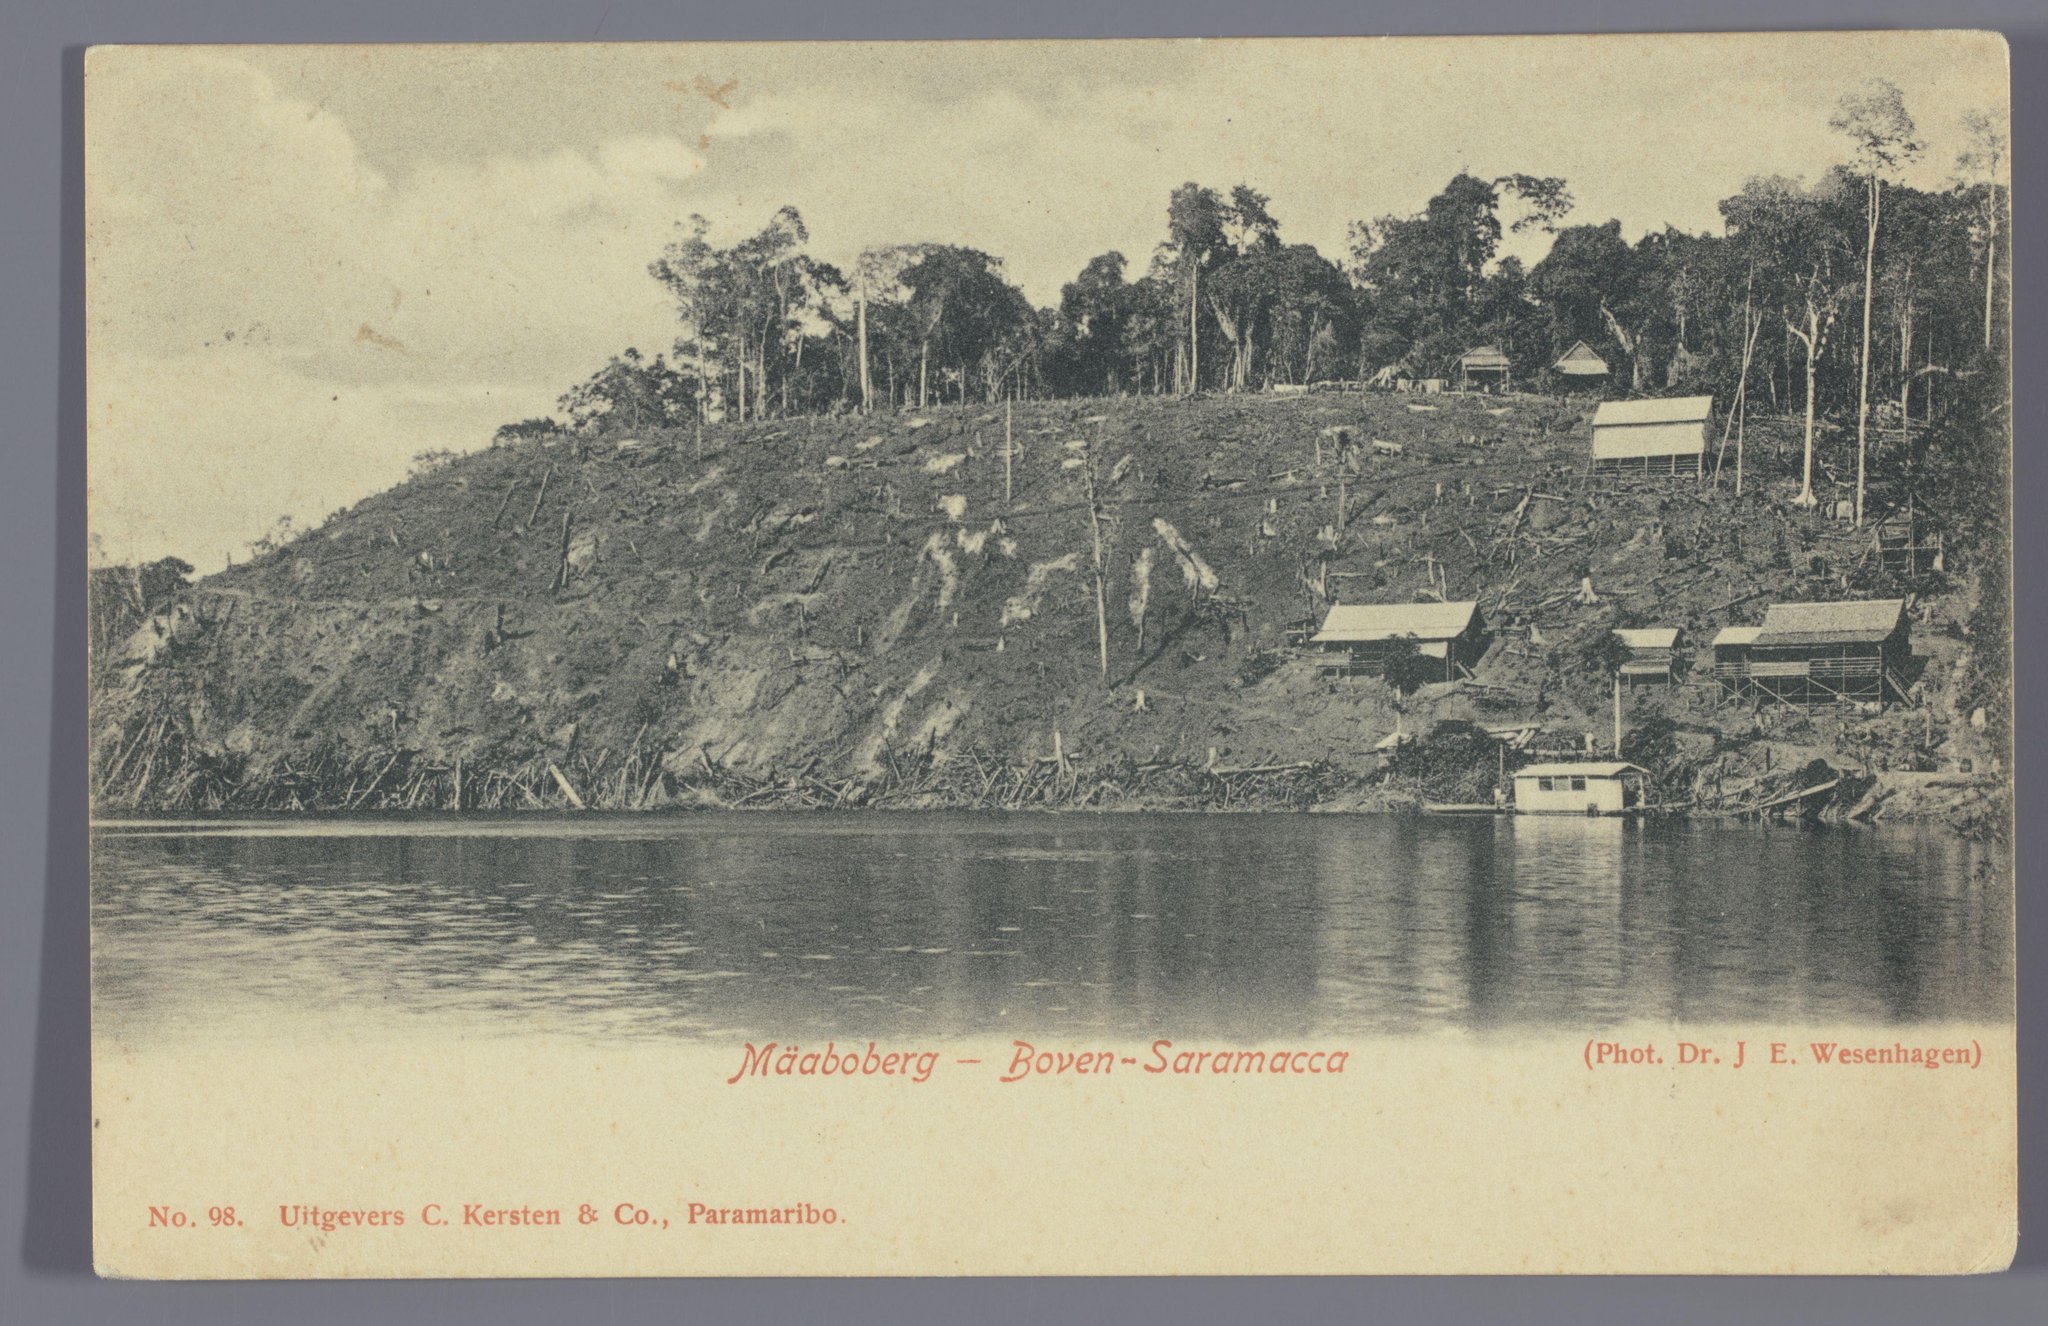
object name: ansichtkaart, prentbriefkaart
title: Gezicht op Mäaboberg, Suriname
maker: jacob evert wesenhagen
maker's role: amateurfotograaf, arts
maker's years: 1862-1924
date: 1905-1910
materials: ink, photographic support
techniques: photograph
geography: paramaribo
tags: landscapes in tropical and sub-tropical regions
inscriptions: stamp, : ‘Mäaboberg - Boven-Saramacca / (Phot. Dr. J.E. Wesenhagen) / No. 98. Uitgevers C. Kersten & Co., Paramaribo’, inscription: ‘Imprimé / [...] Mons. / N. sanders / p.a. [...] / 32 Rue Etienne Marcel / Paris’